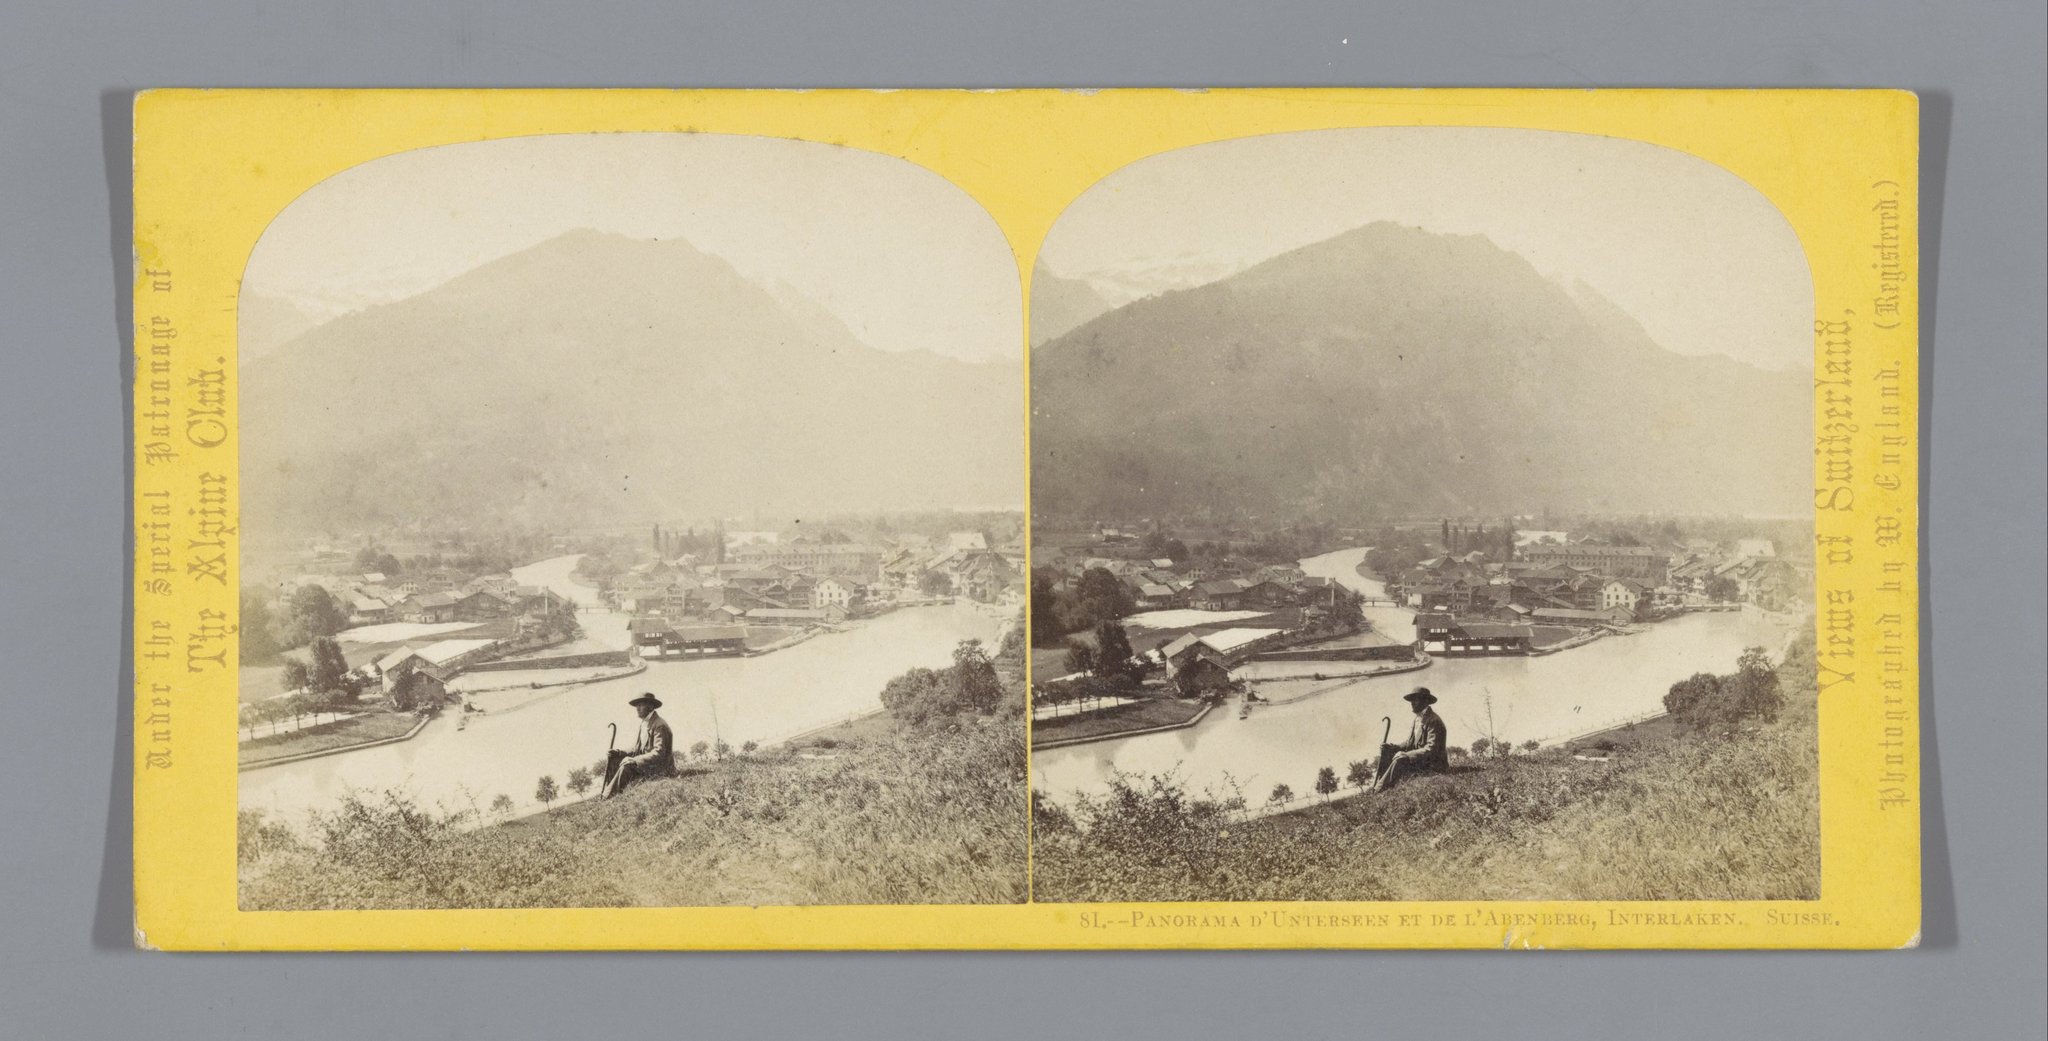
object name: stereograph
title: Gezicht op Unterseen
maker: william england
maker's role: fotograaf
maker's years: 1816-1896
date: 1850-1880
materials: cardboard, photographic support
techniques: albumen print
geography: bern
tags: city-view in general; 'veduta', mountains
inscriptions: inscription: ‘Views of Switzerland, photographed by W. England. (Registered) Under the Special Patronage of the Alpine Club.’, number: ‘81.’